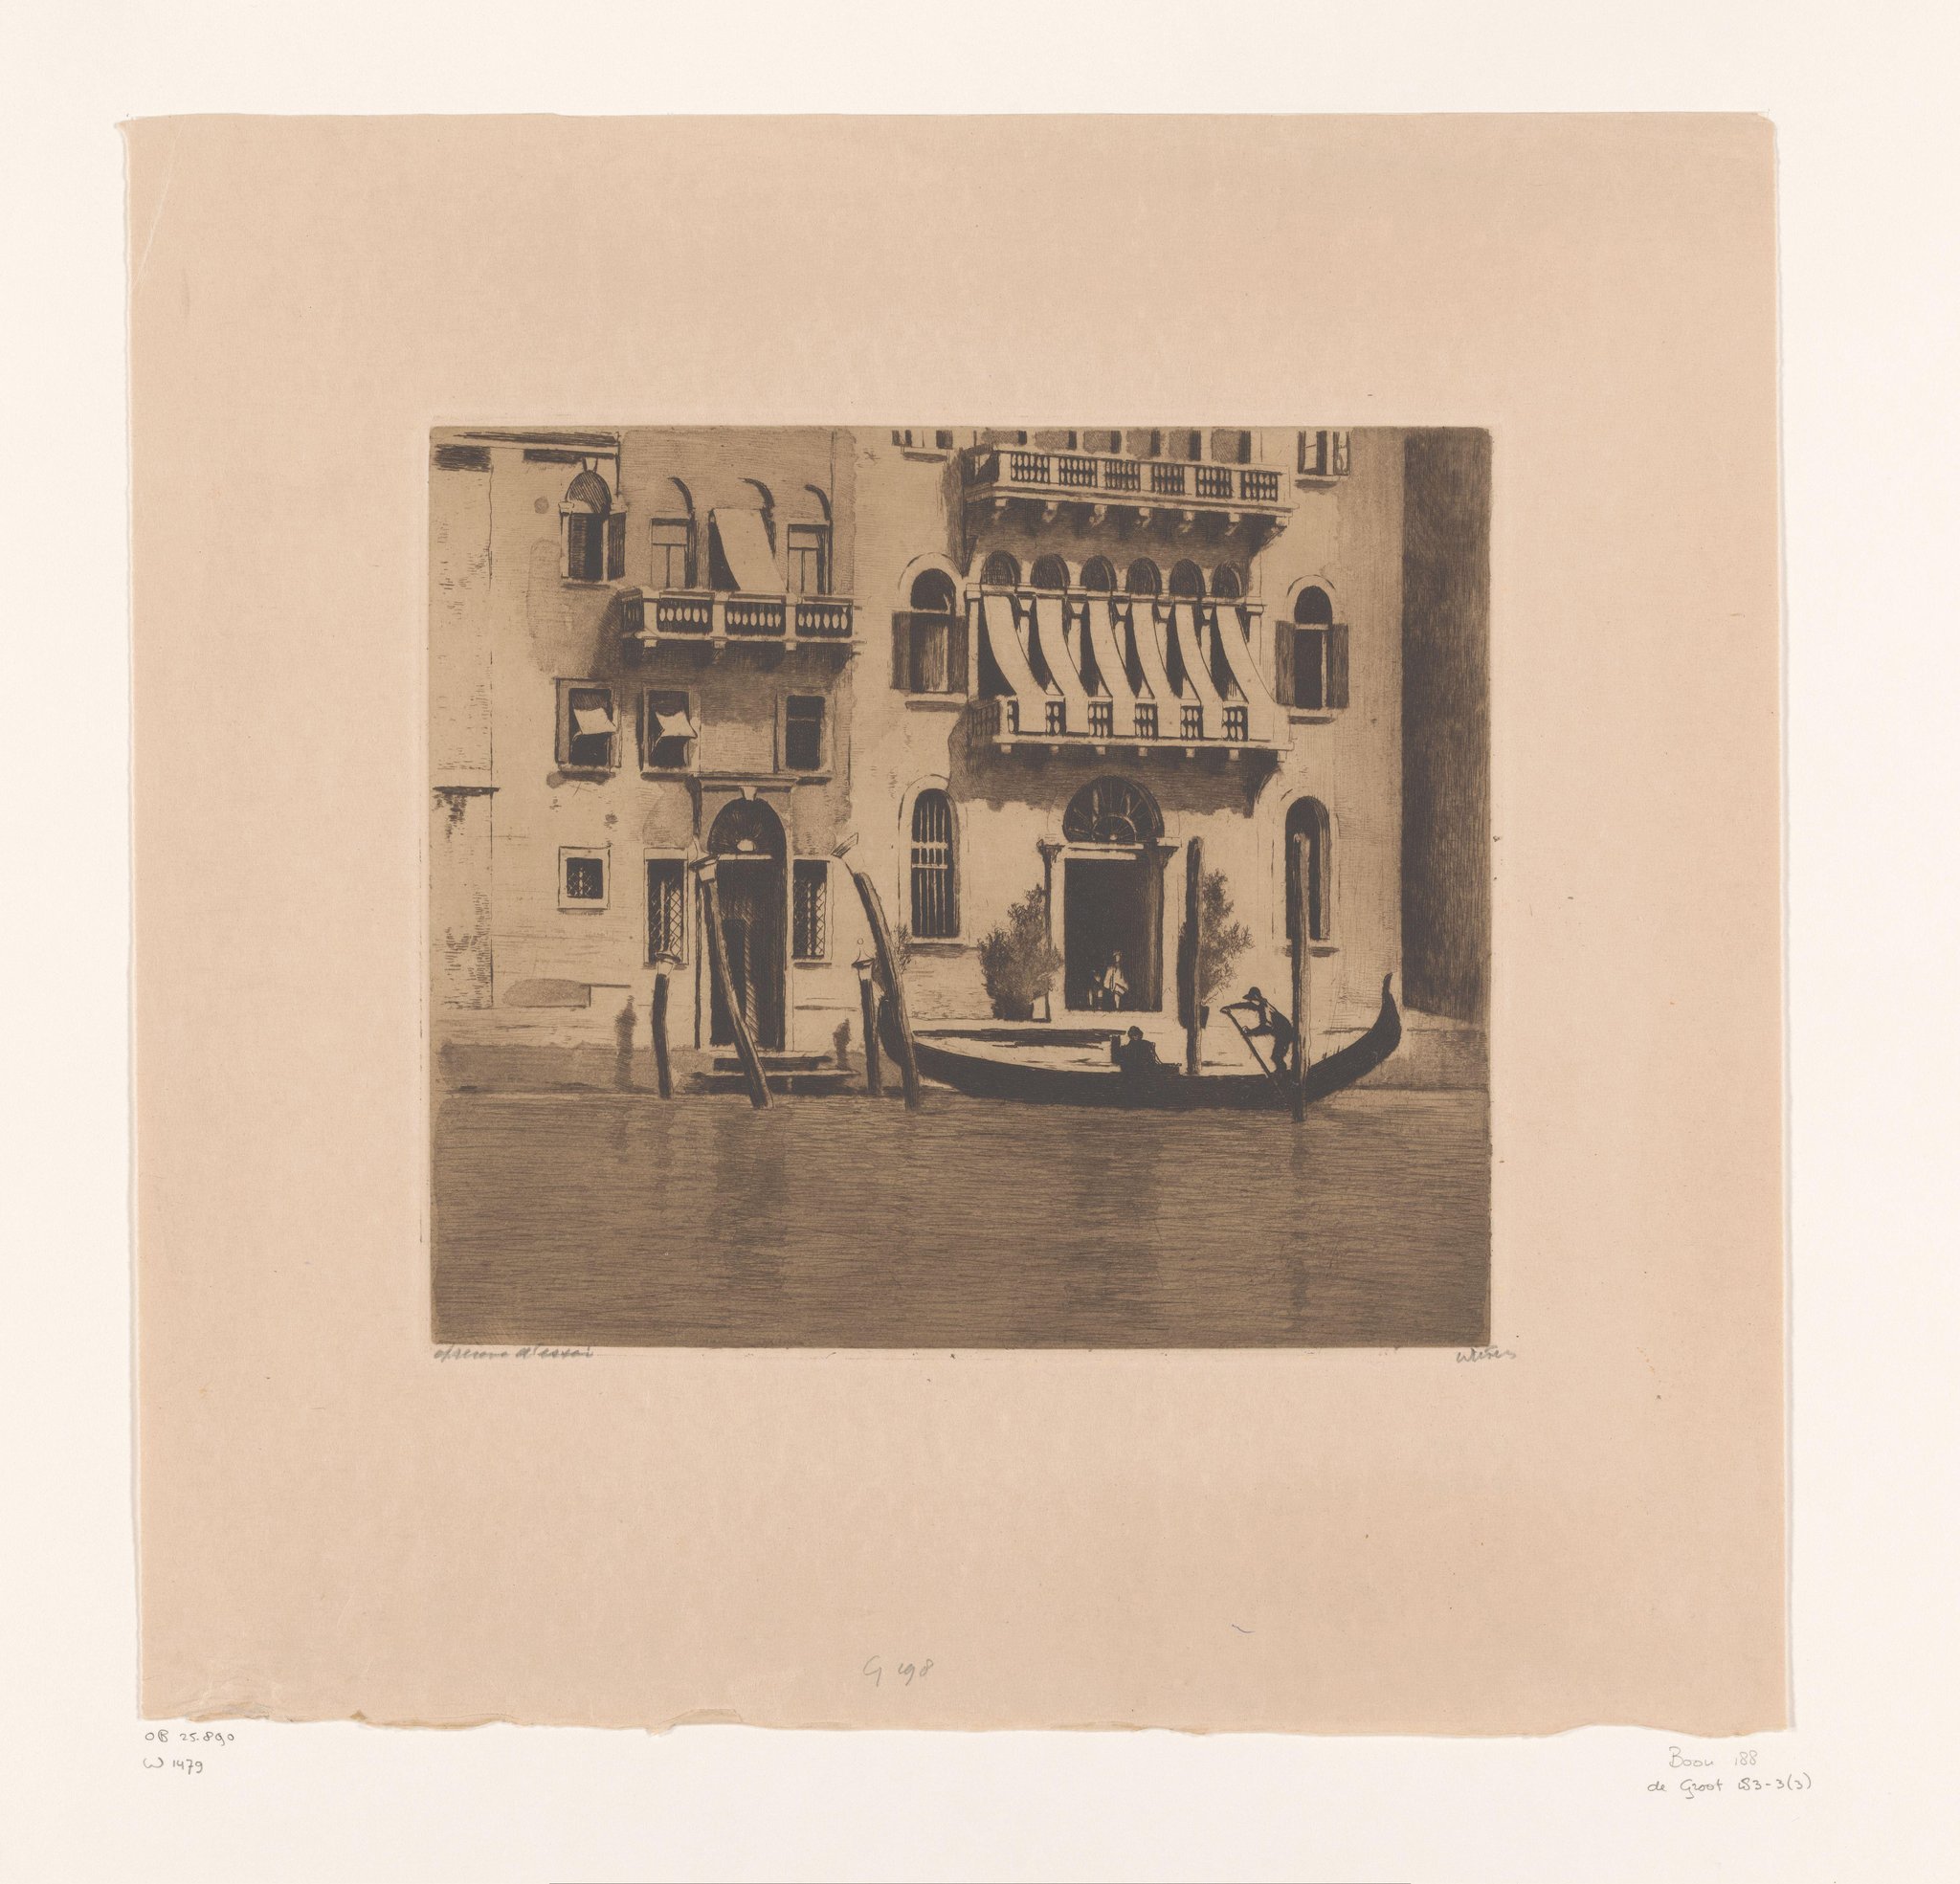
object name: print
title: Gondelier boomt een gondel langs gevels aan het Canal Grande in Venetië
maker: willem witsen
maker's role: draughtsman, painter, print maker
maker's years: 1860-1923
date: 1914-1919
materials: paper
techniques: aquatint, etching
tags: canals, waters (in city), gondola, venice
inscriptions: annotation: ‘épreuve d'essai’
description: Is naar alle waarschijnlijkheid gebaseerd op de Palazzi Businelli en Lanfranchi aan de San Polo-zijde van het Canal Grande.